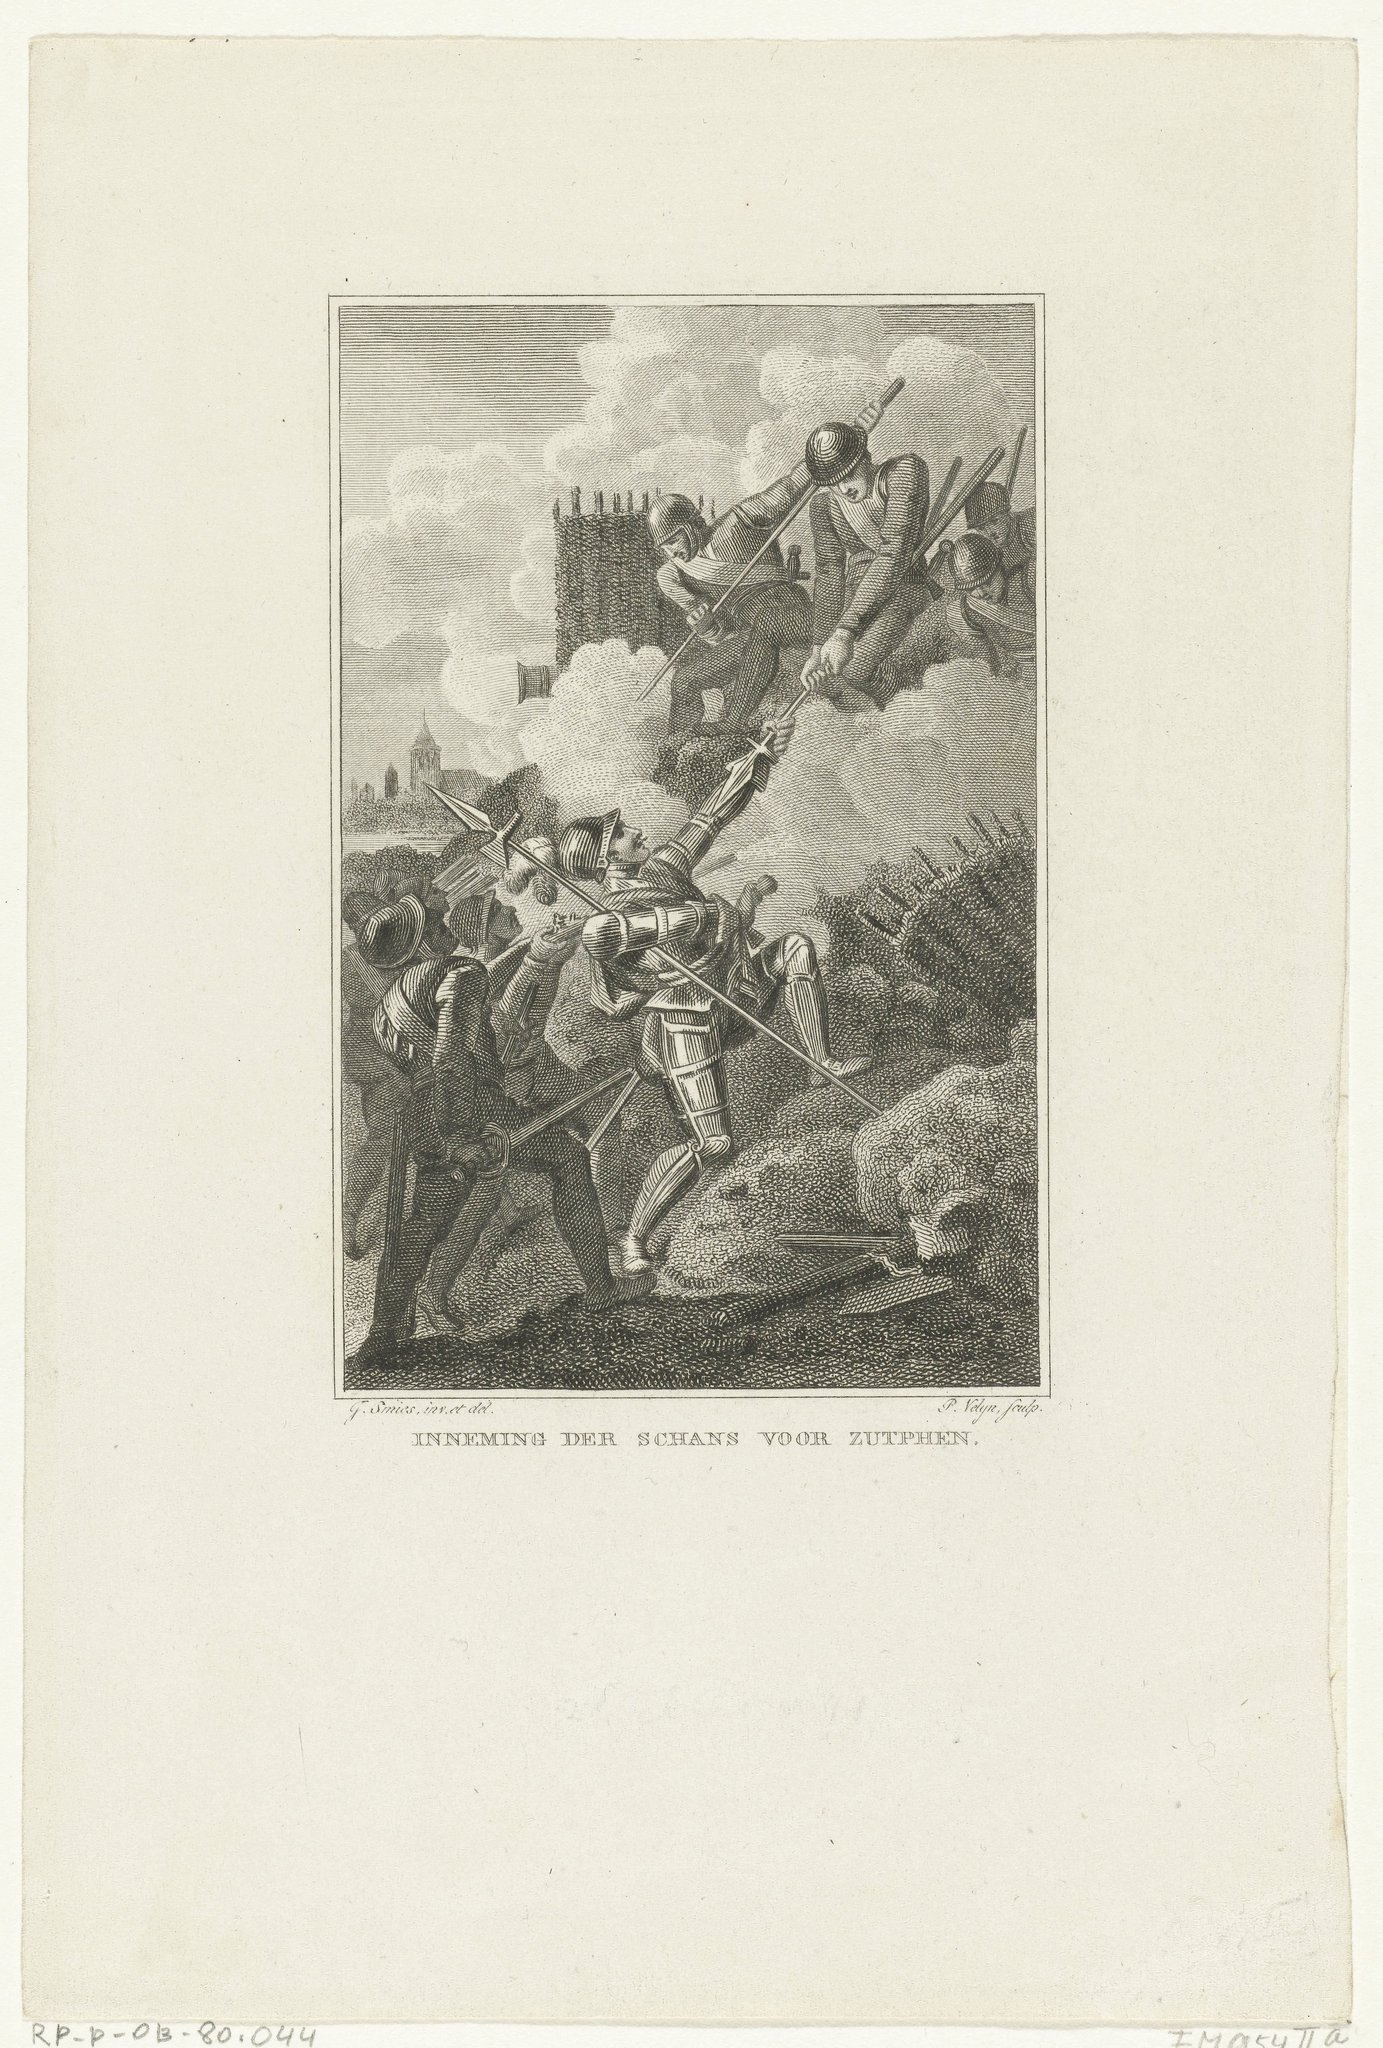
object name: history print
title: Inneming der schans voor Zutphen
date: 1823-1829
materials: paper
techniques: engraving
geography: netherlands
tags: robert dudley (1st earl of leicester), siege, position war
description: Gebruikt als illustratie in: P.G. Witsen Geysbeek en G. Engelberts Gerrits, Schoonheden en merkwaardige tafereelen uit de Nederlandsche geschiedenis. G. Portielje, Amsterdam 1825-1829, 8 delen. Staat met de letter. Niet in Frederik Muller; door het RPK toegevoegd nummer.